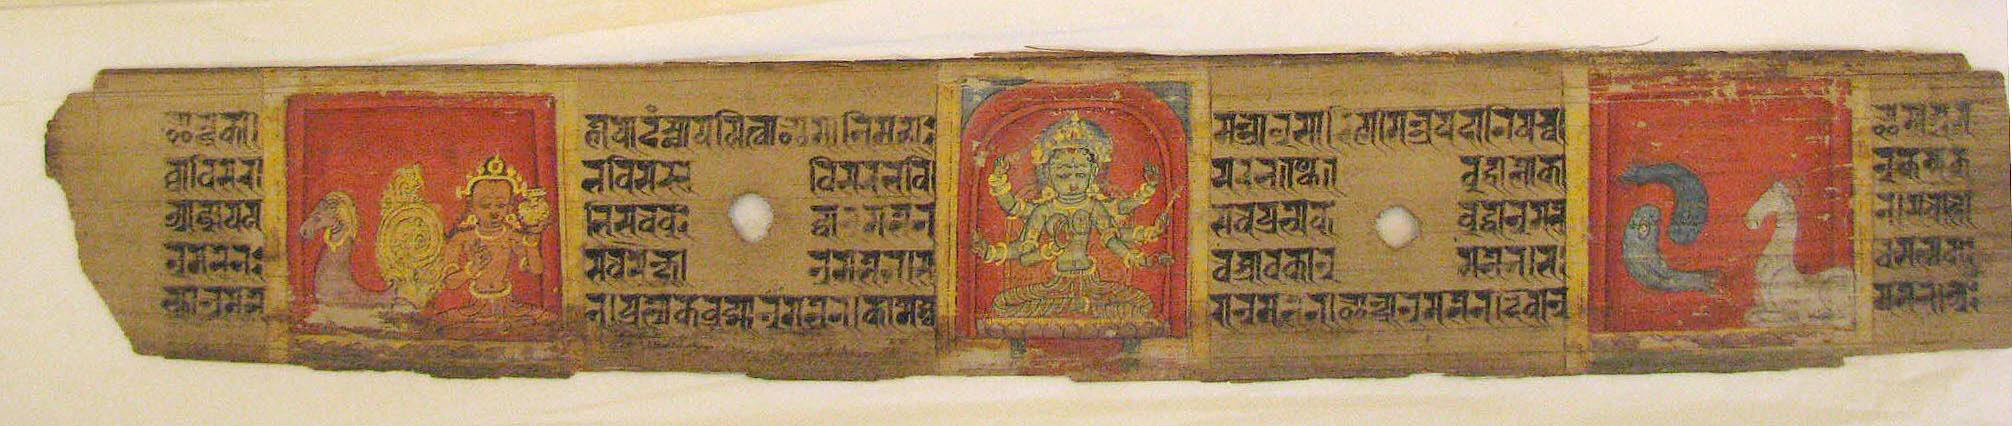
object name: folio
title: Leaf from an Illuminated Buddhist Manuscript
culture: nepali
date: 1301-1400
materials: ink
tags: buddhism,deities